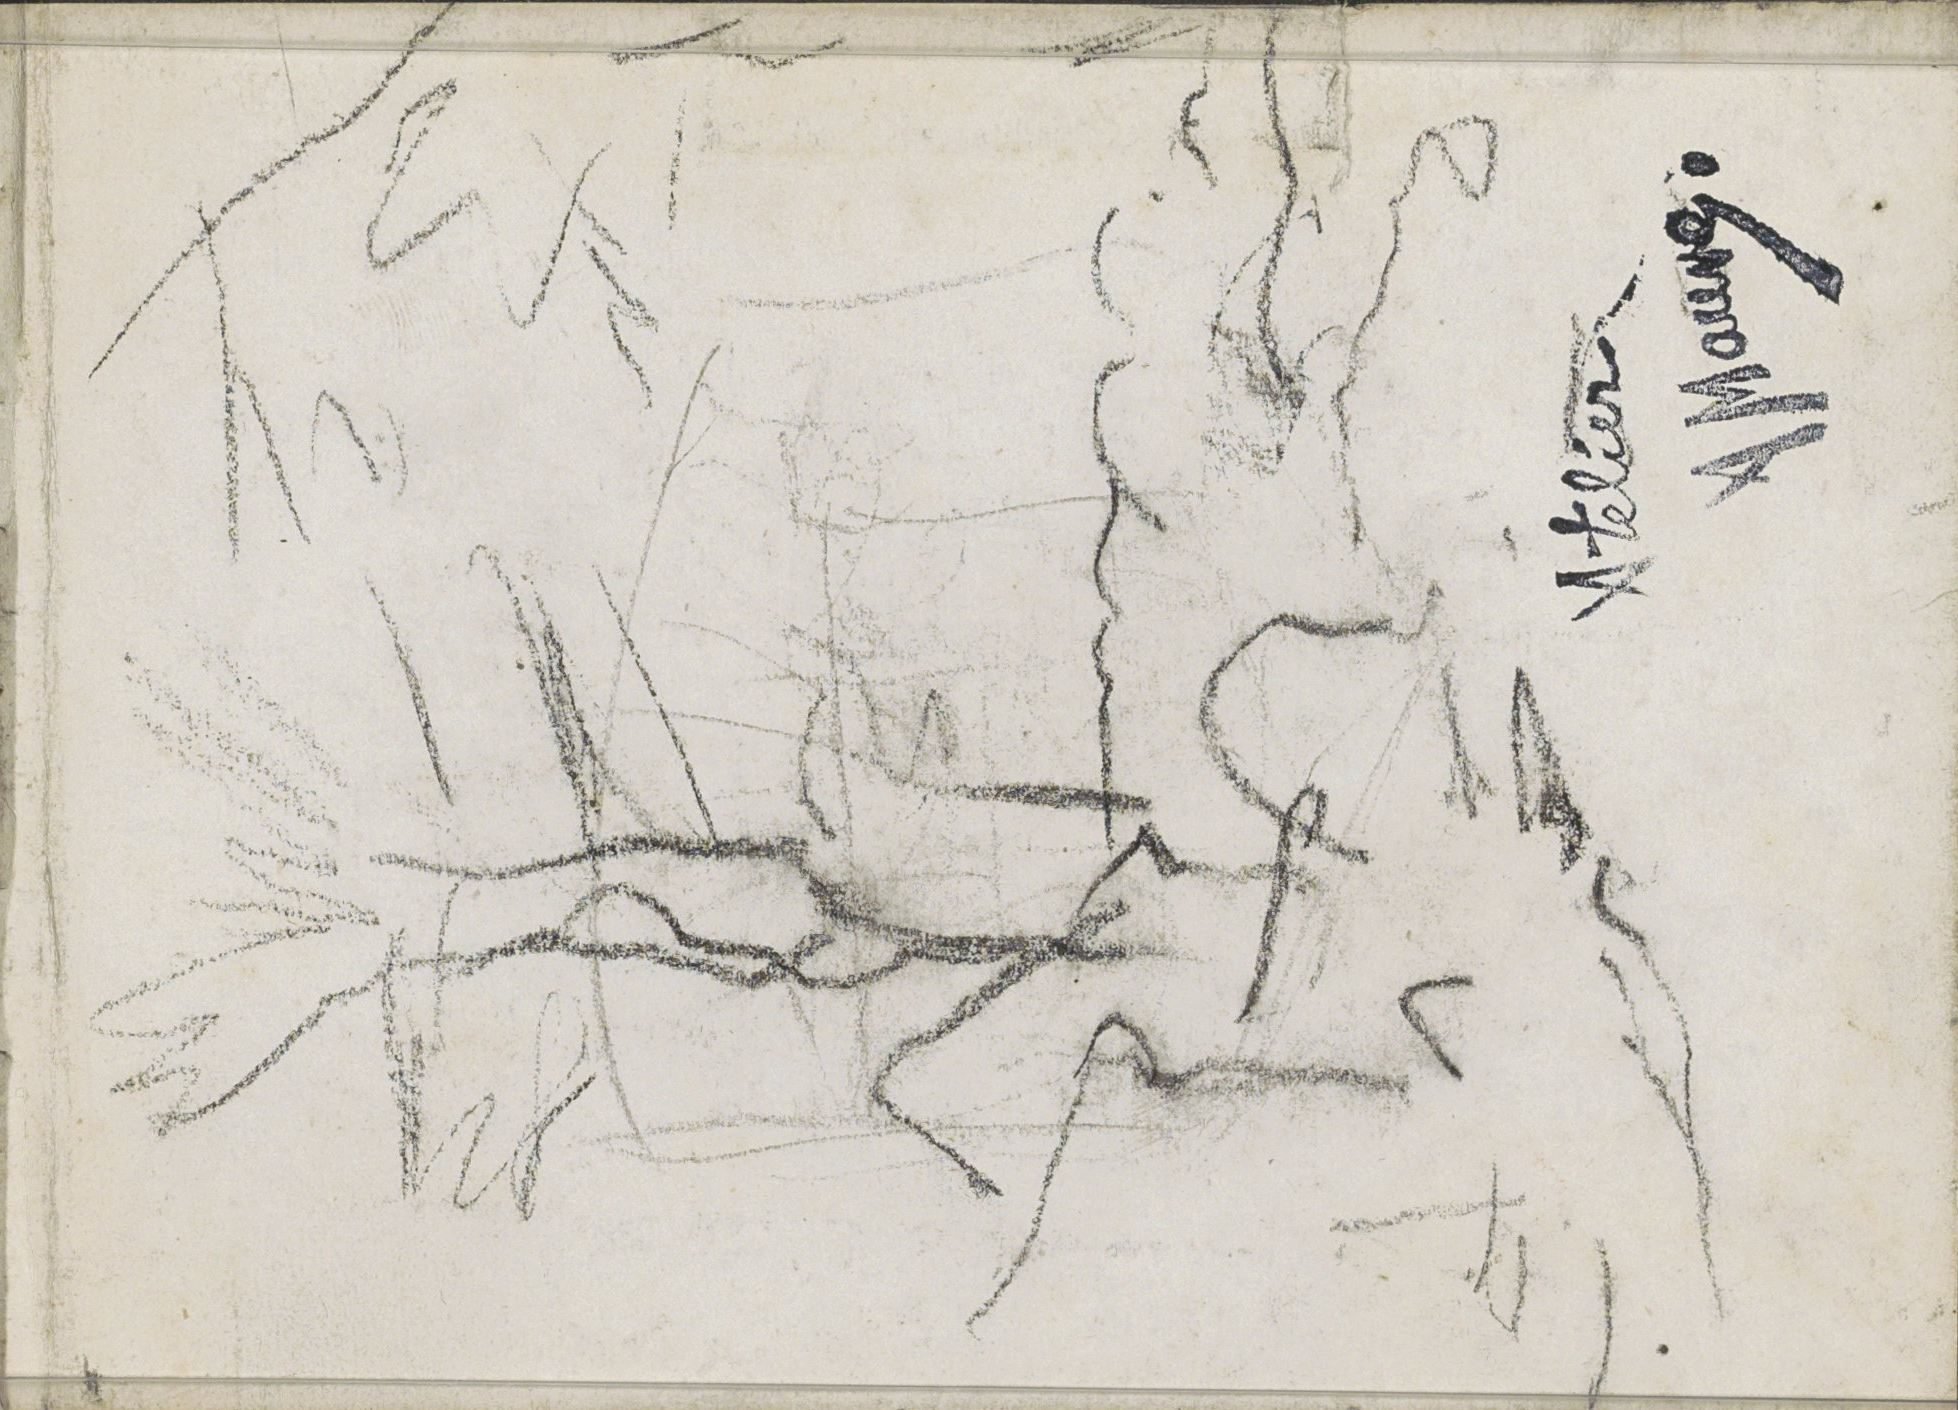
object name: sketchbook leaf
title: Landschap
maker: anton mauve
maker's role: draughtsman, painter, print maker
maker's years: 1838-1888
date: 1848-1888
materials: chalk, paper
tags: landscapes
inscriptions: workshop stamp: ‘Atelier/ A Mauve.’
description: Achterste schutblad uit een schetsboek met 31 bladen.